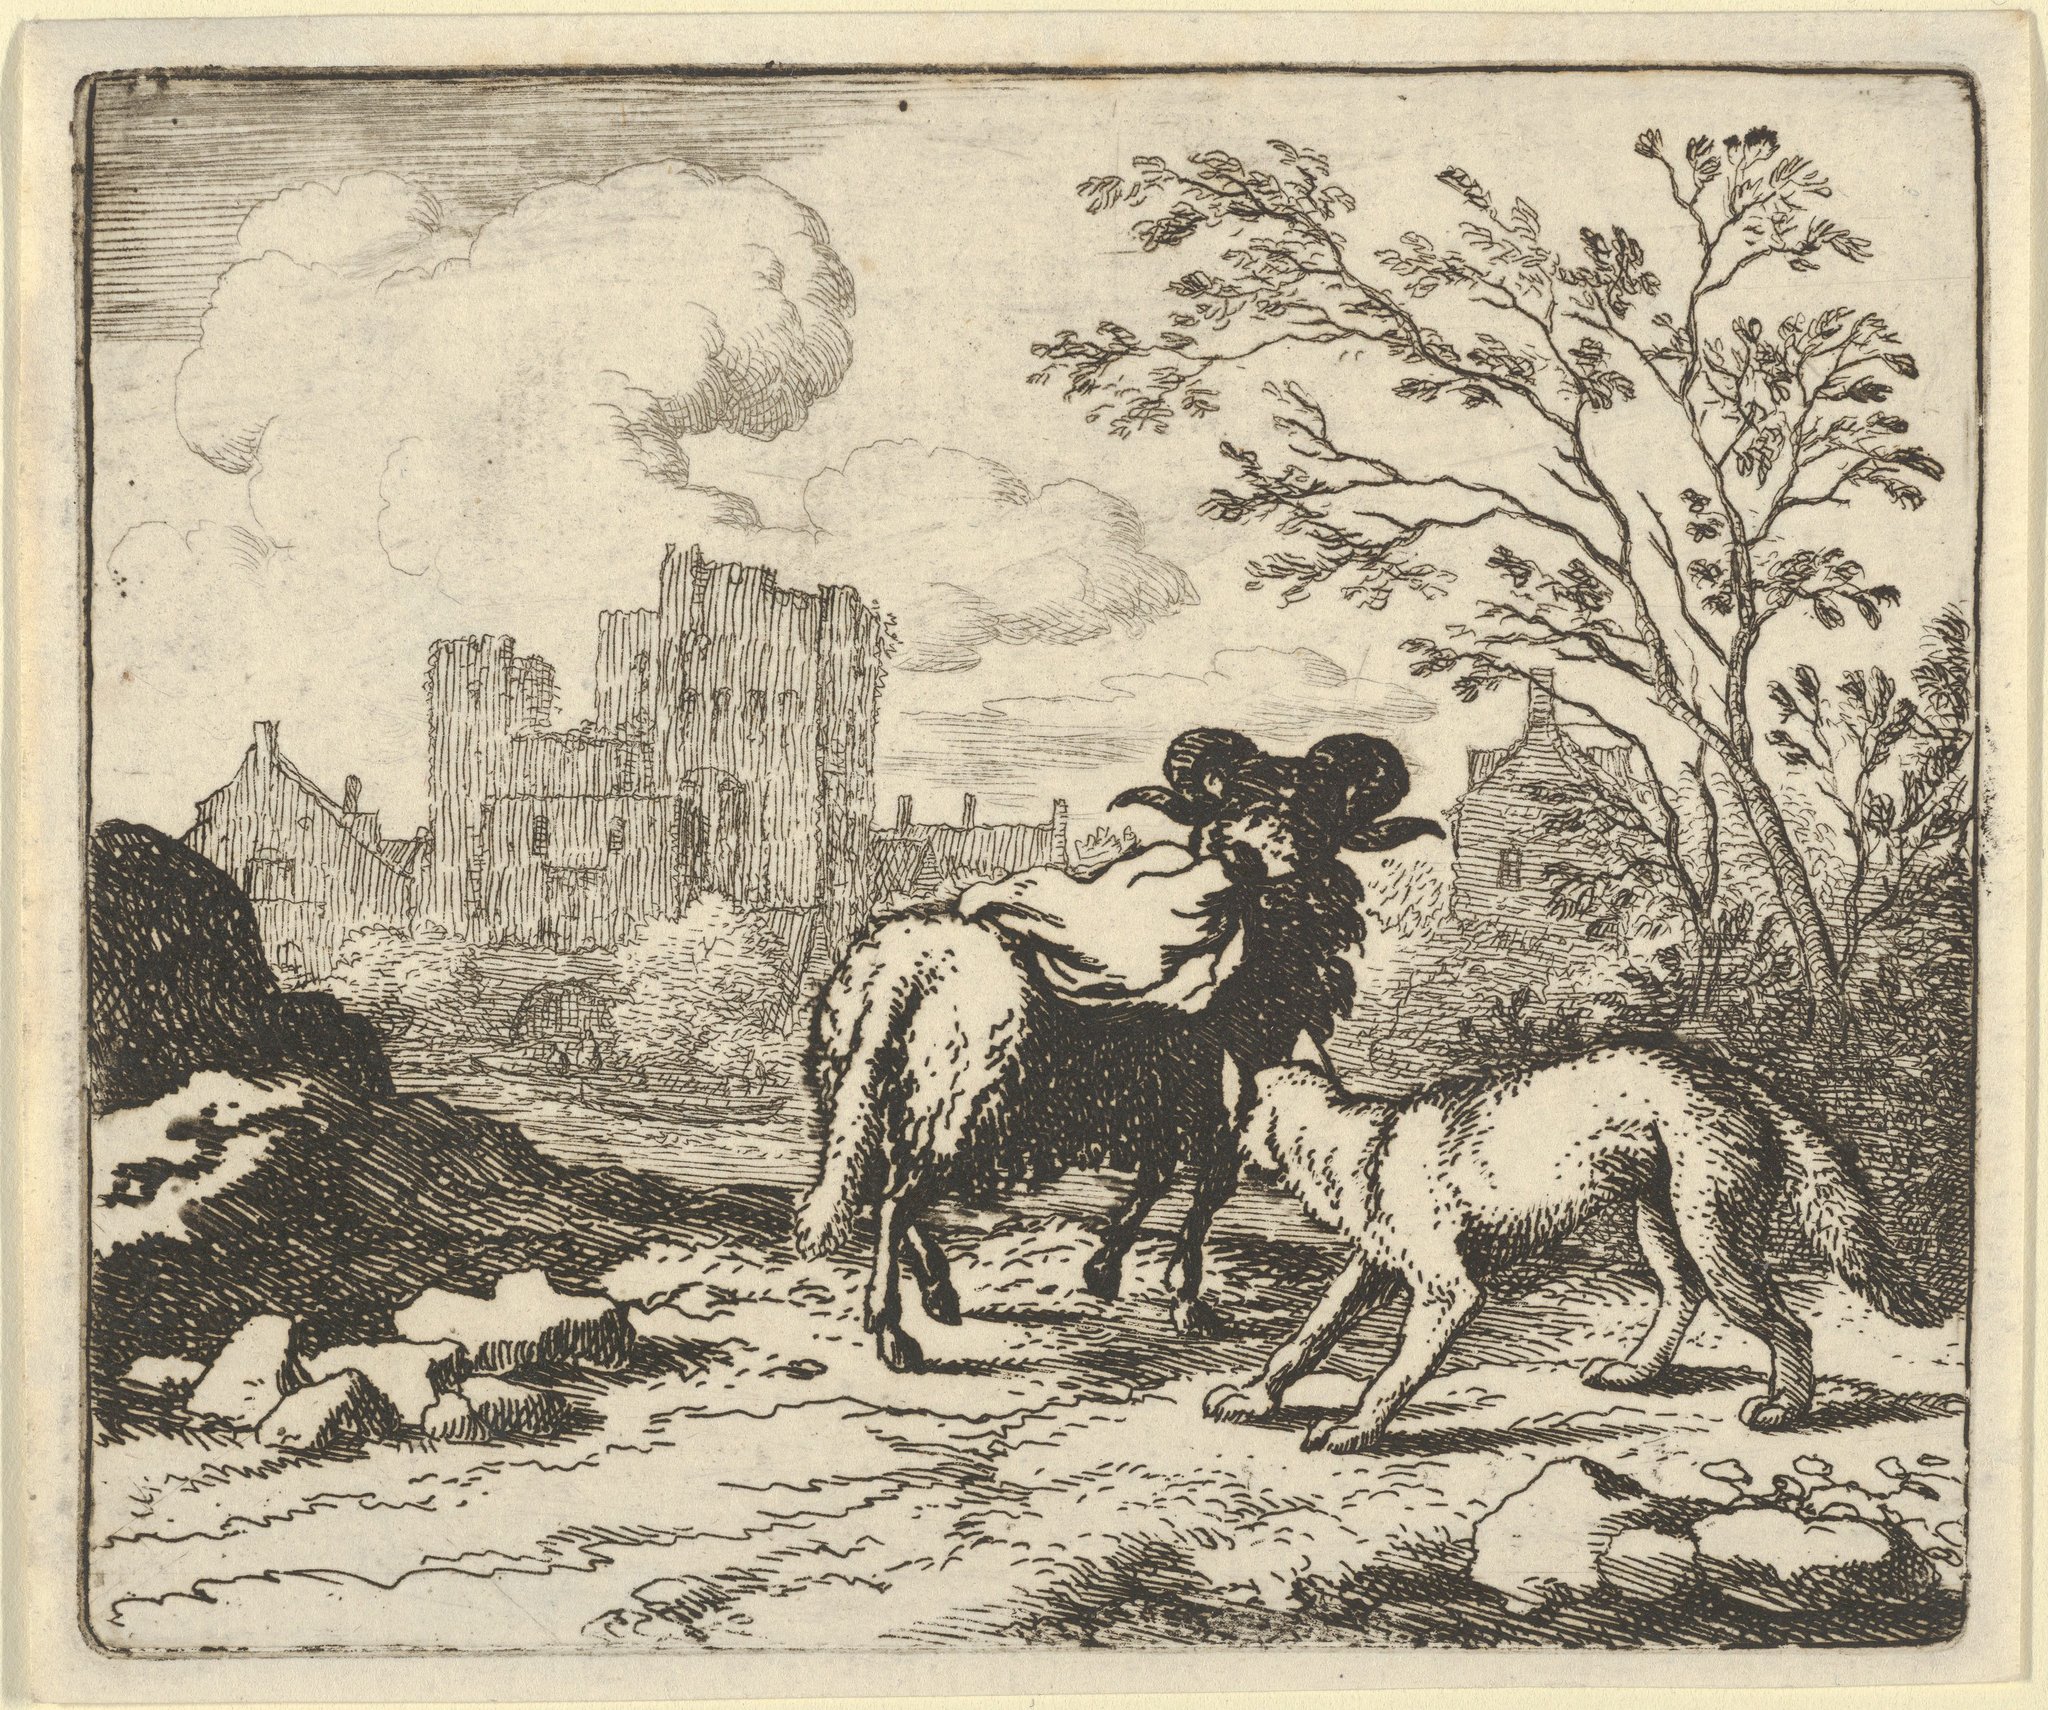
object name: print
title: Renard Sends the Ram Back to the Lion with a Package Containing the Rabbit's Head from Hendrick van Alcmar's Renard The Fox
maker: allart van everdingen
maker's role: artist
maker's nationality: dutch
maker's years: 1621-1675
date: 1650-1675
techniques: engraving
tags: buildings,foxes,rams,trees